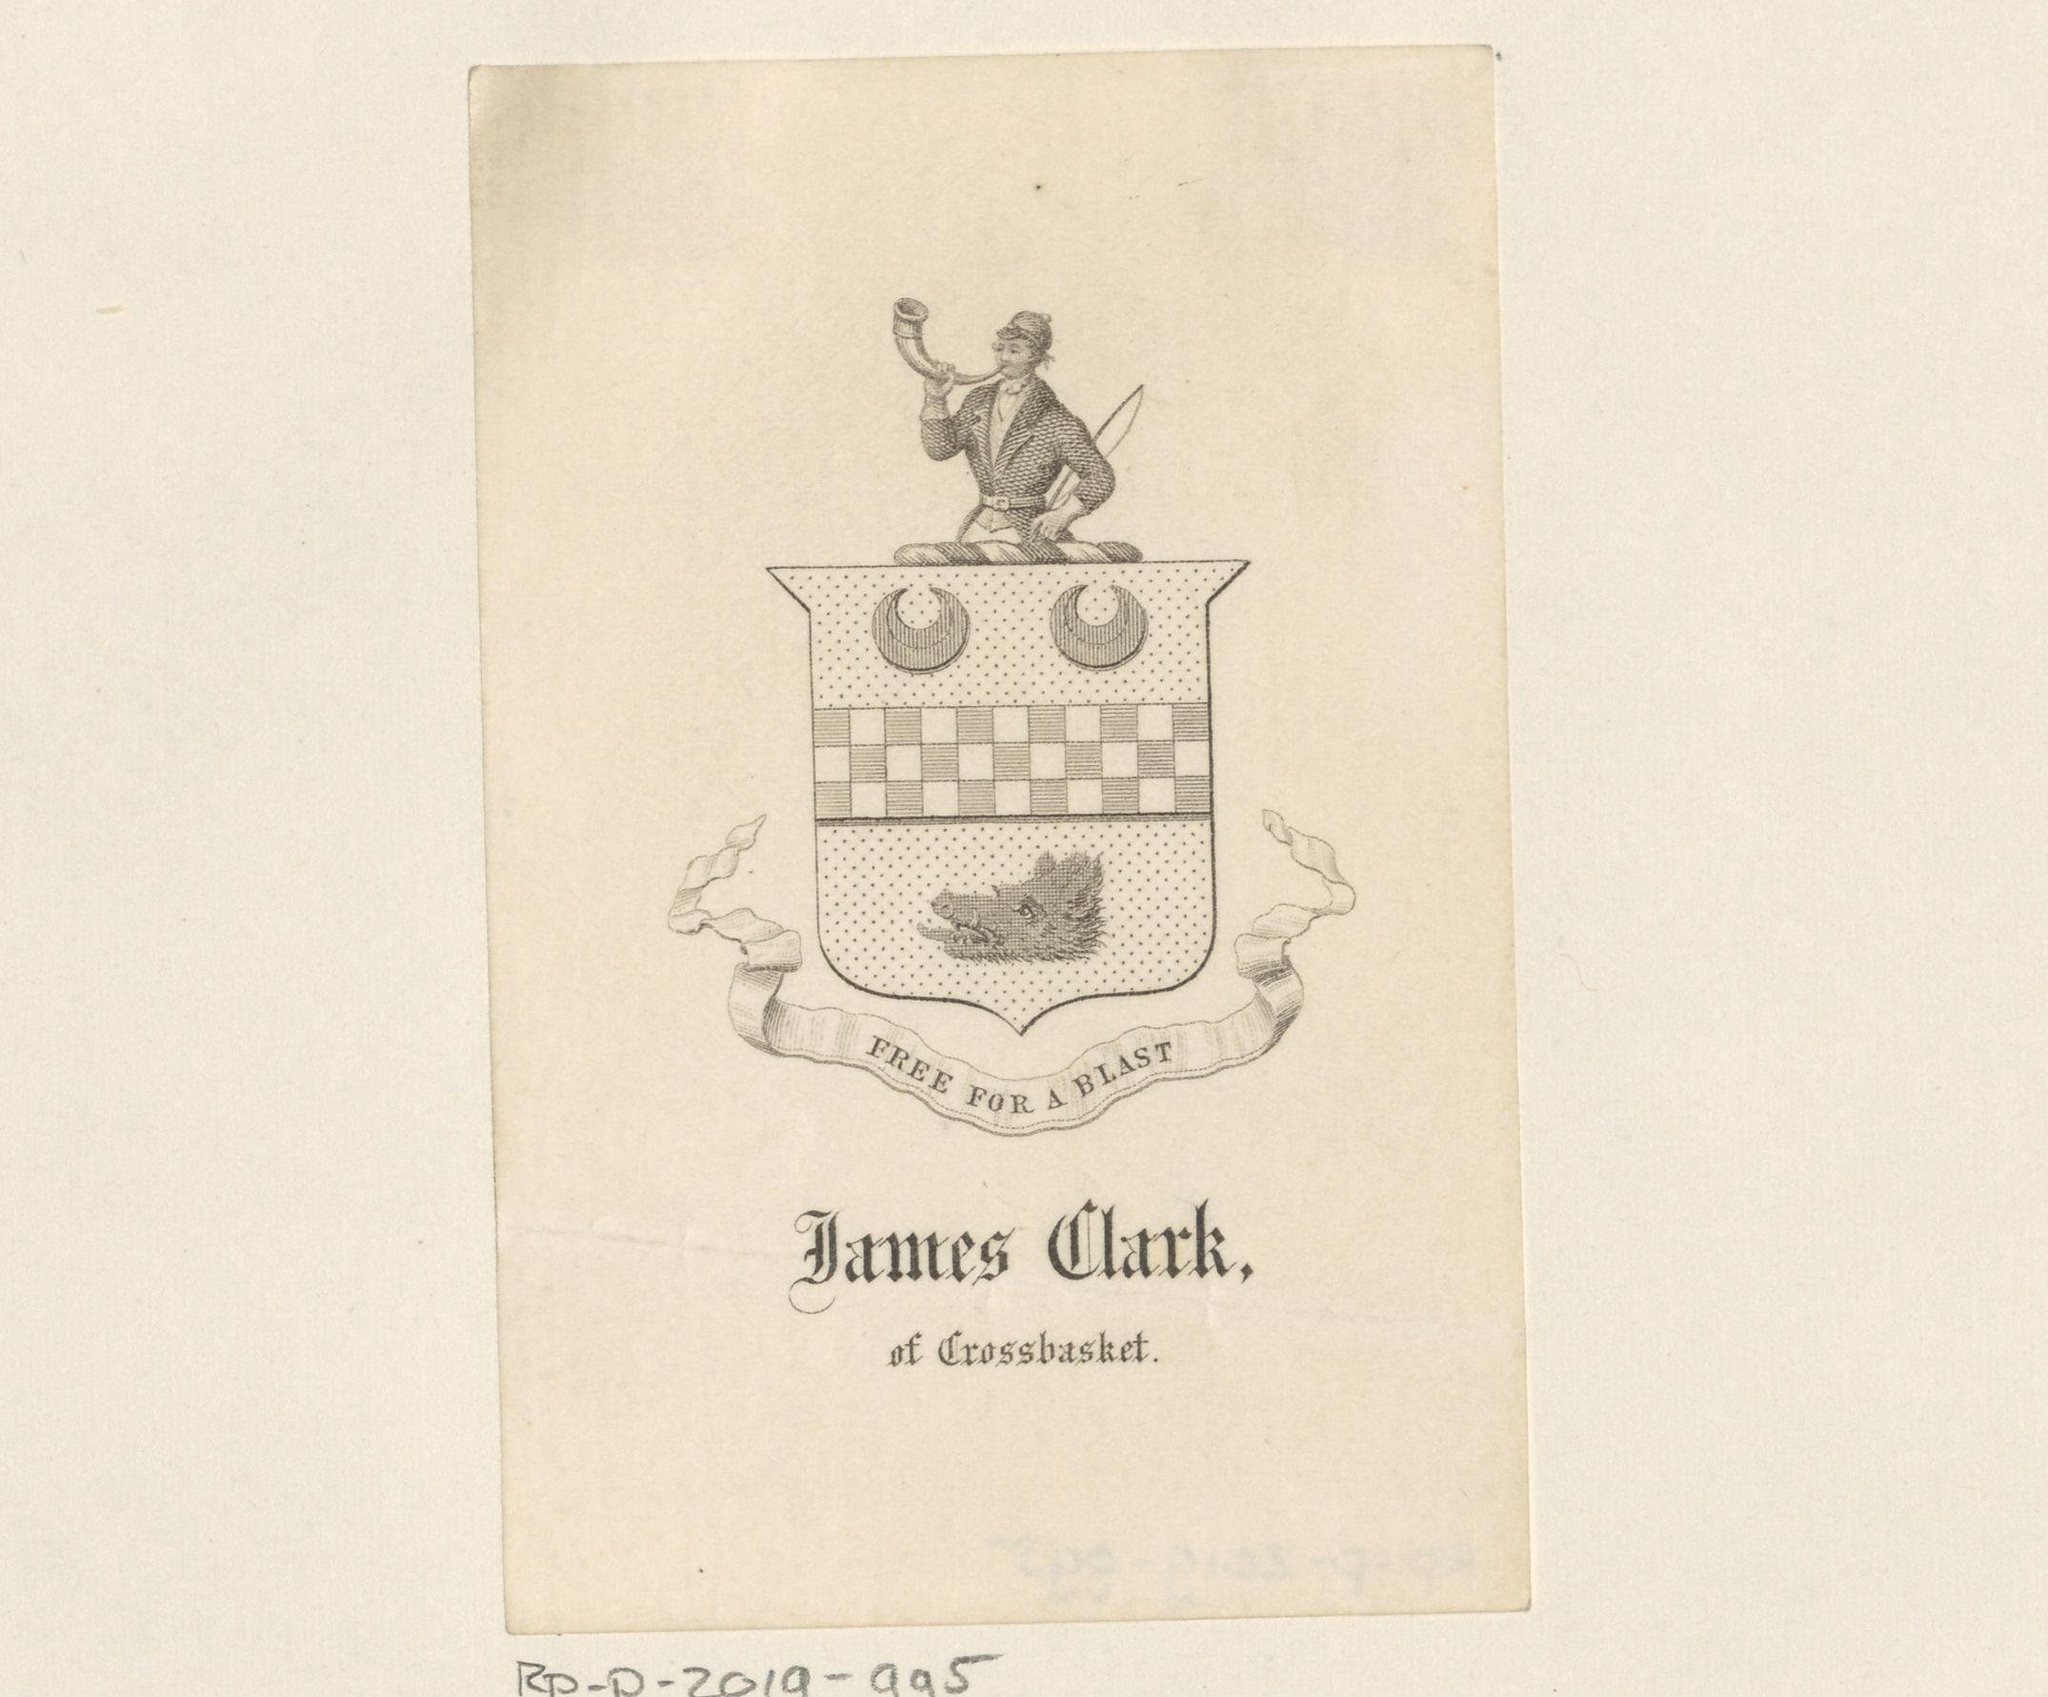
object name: bookplate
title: Free for a blast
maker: Anonymous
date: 1823-1859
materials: paper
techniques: engraving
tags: armorial bearing, heraldry